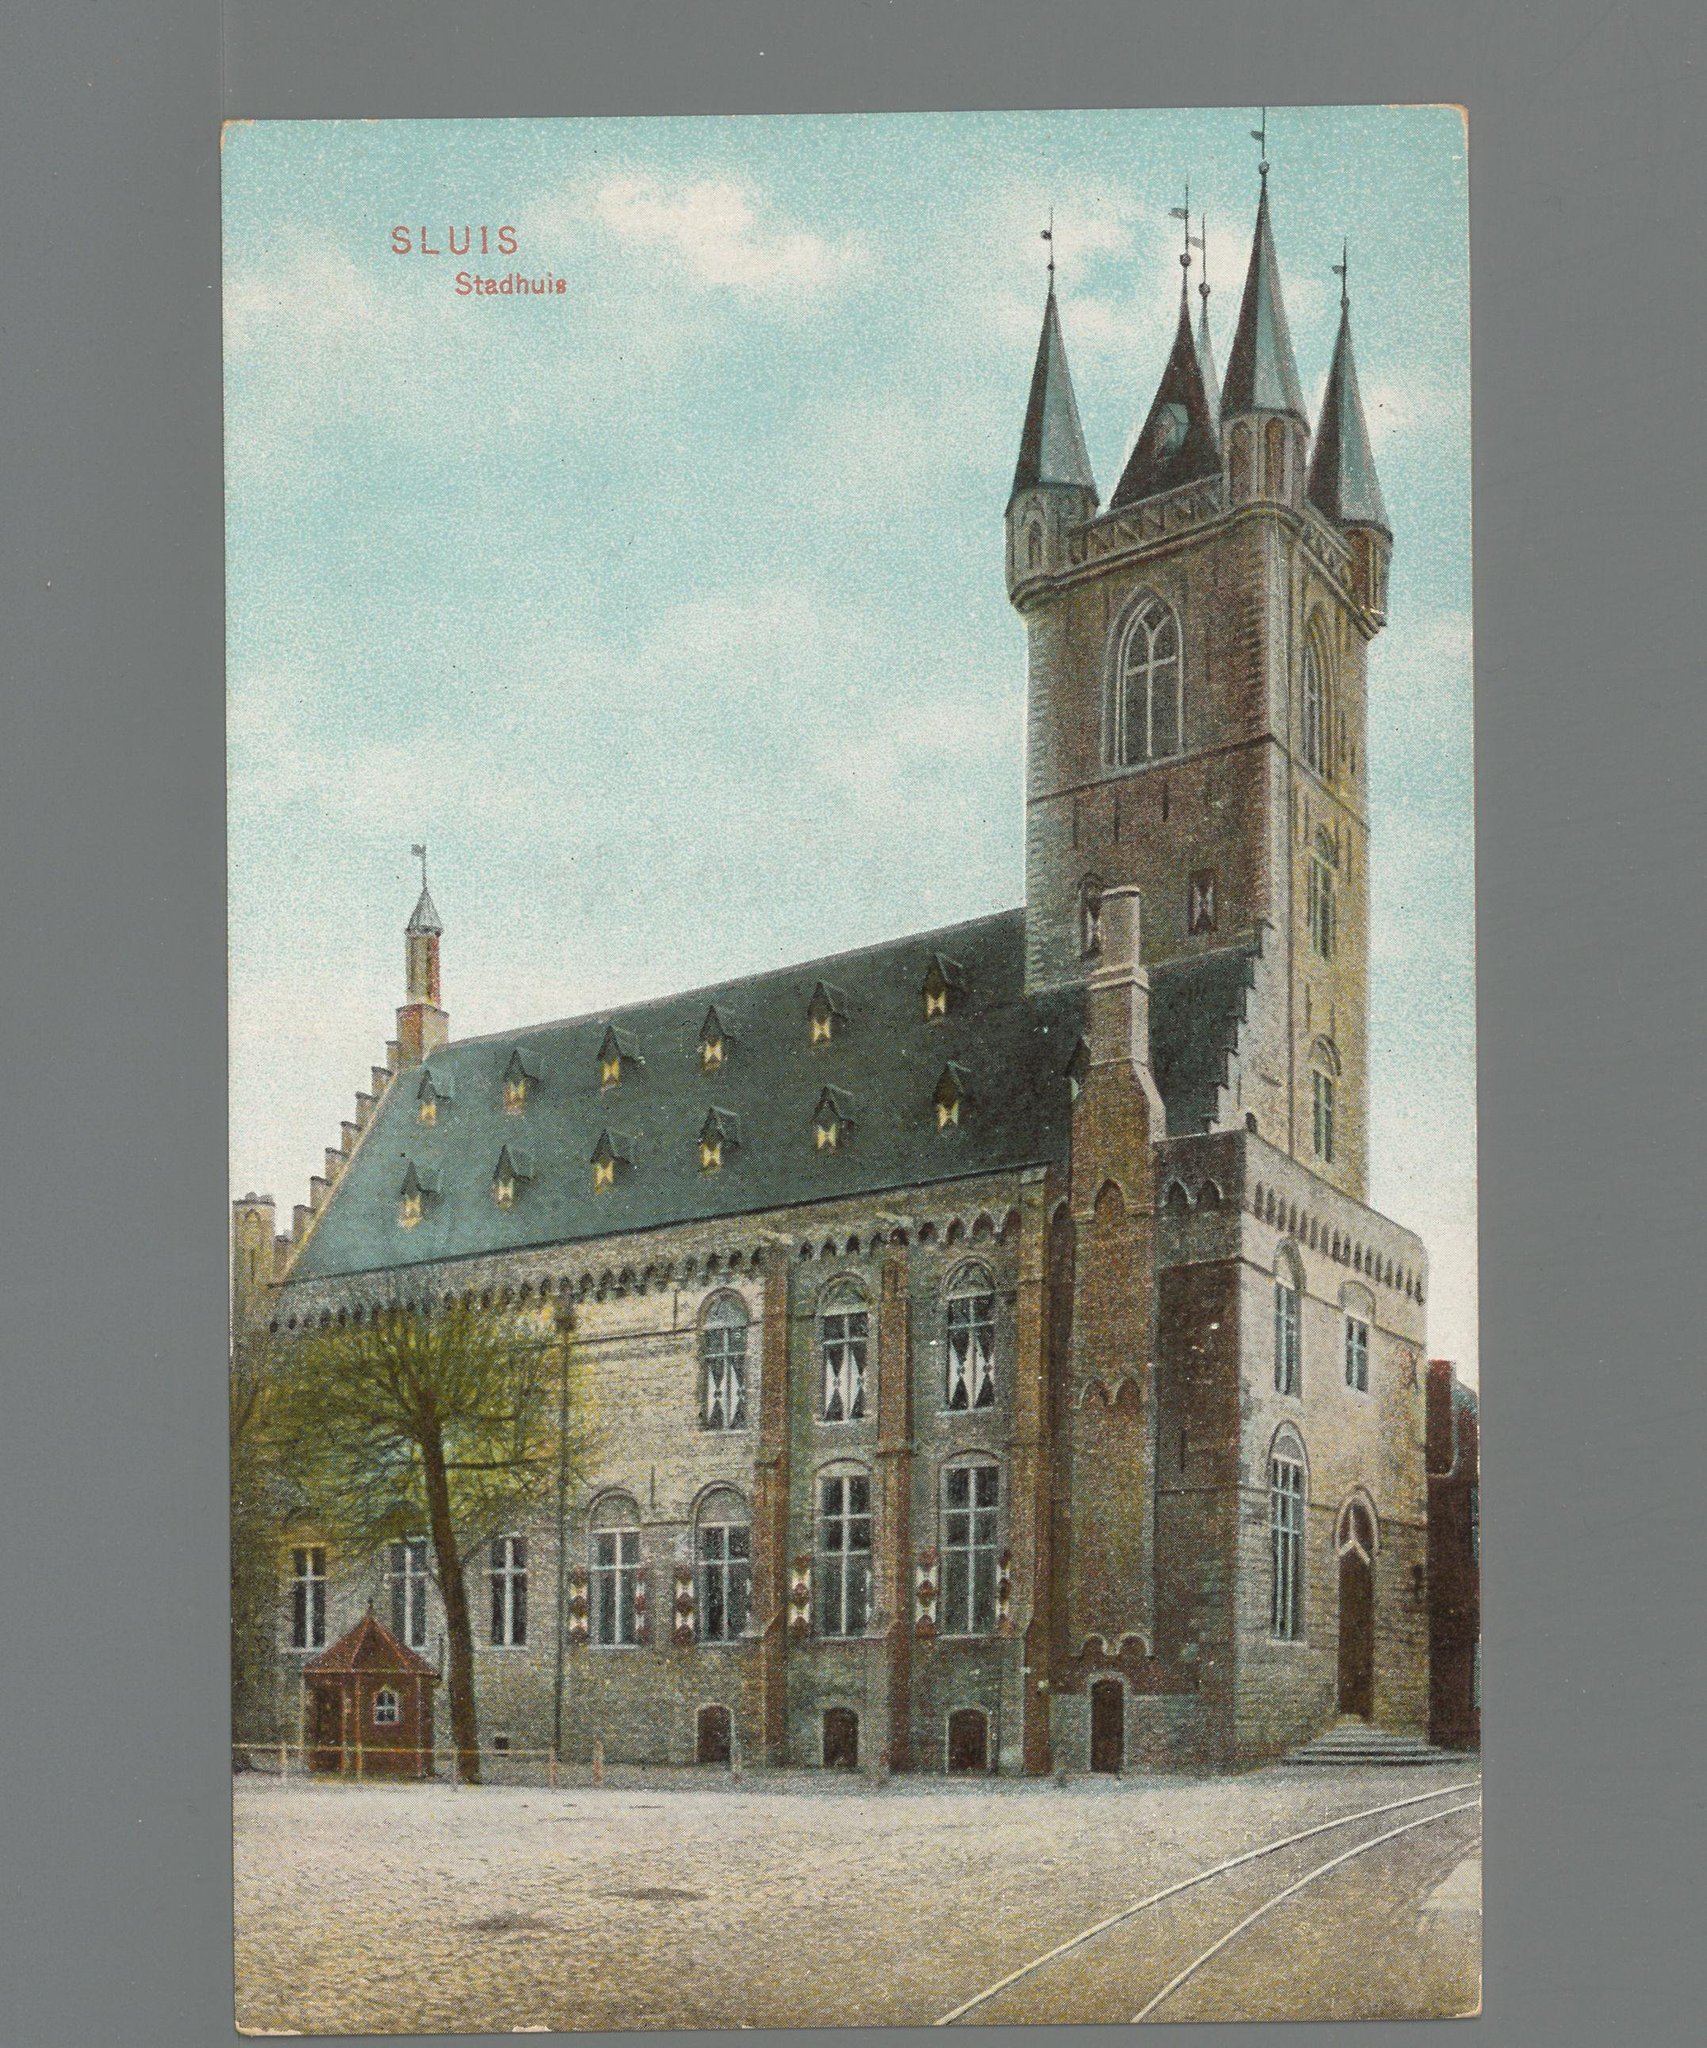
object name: ansichtkaart, prentbriefkaart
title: Sluis, Stadhuis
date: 1905-1930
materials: cardboard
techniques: lithograph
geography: terneuzen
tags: townhall